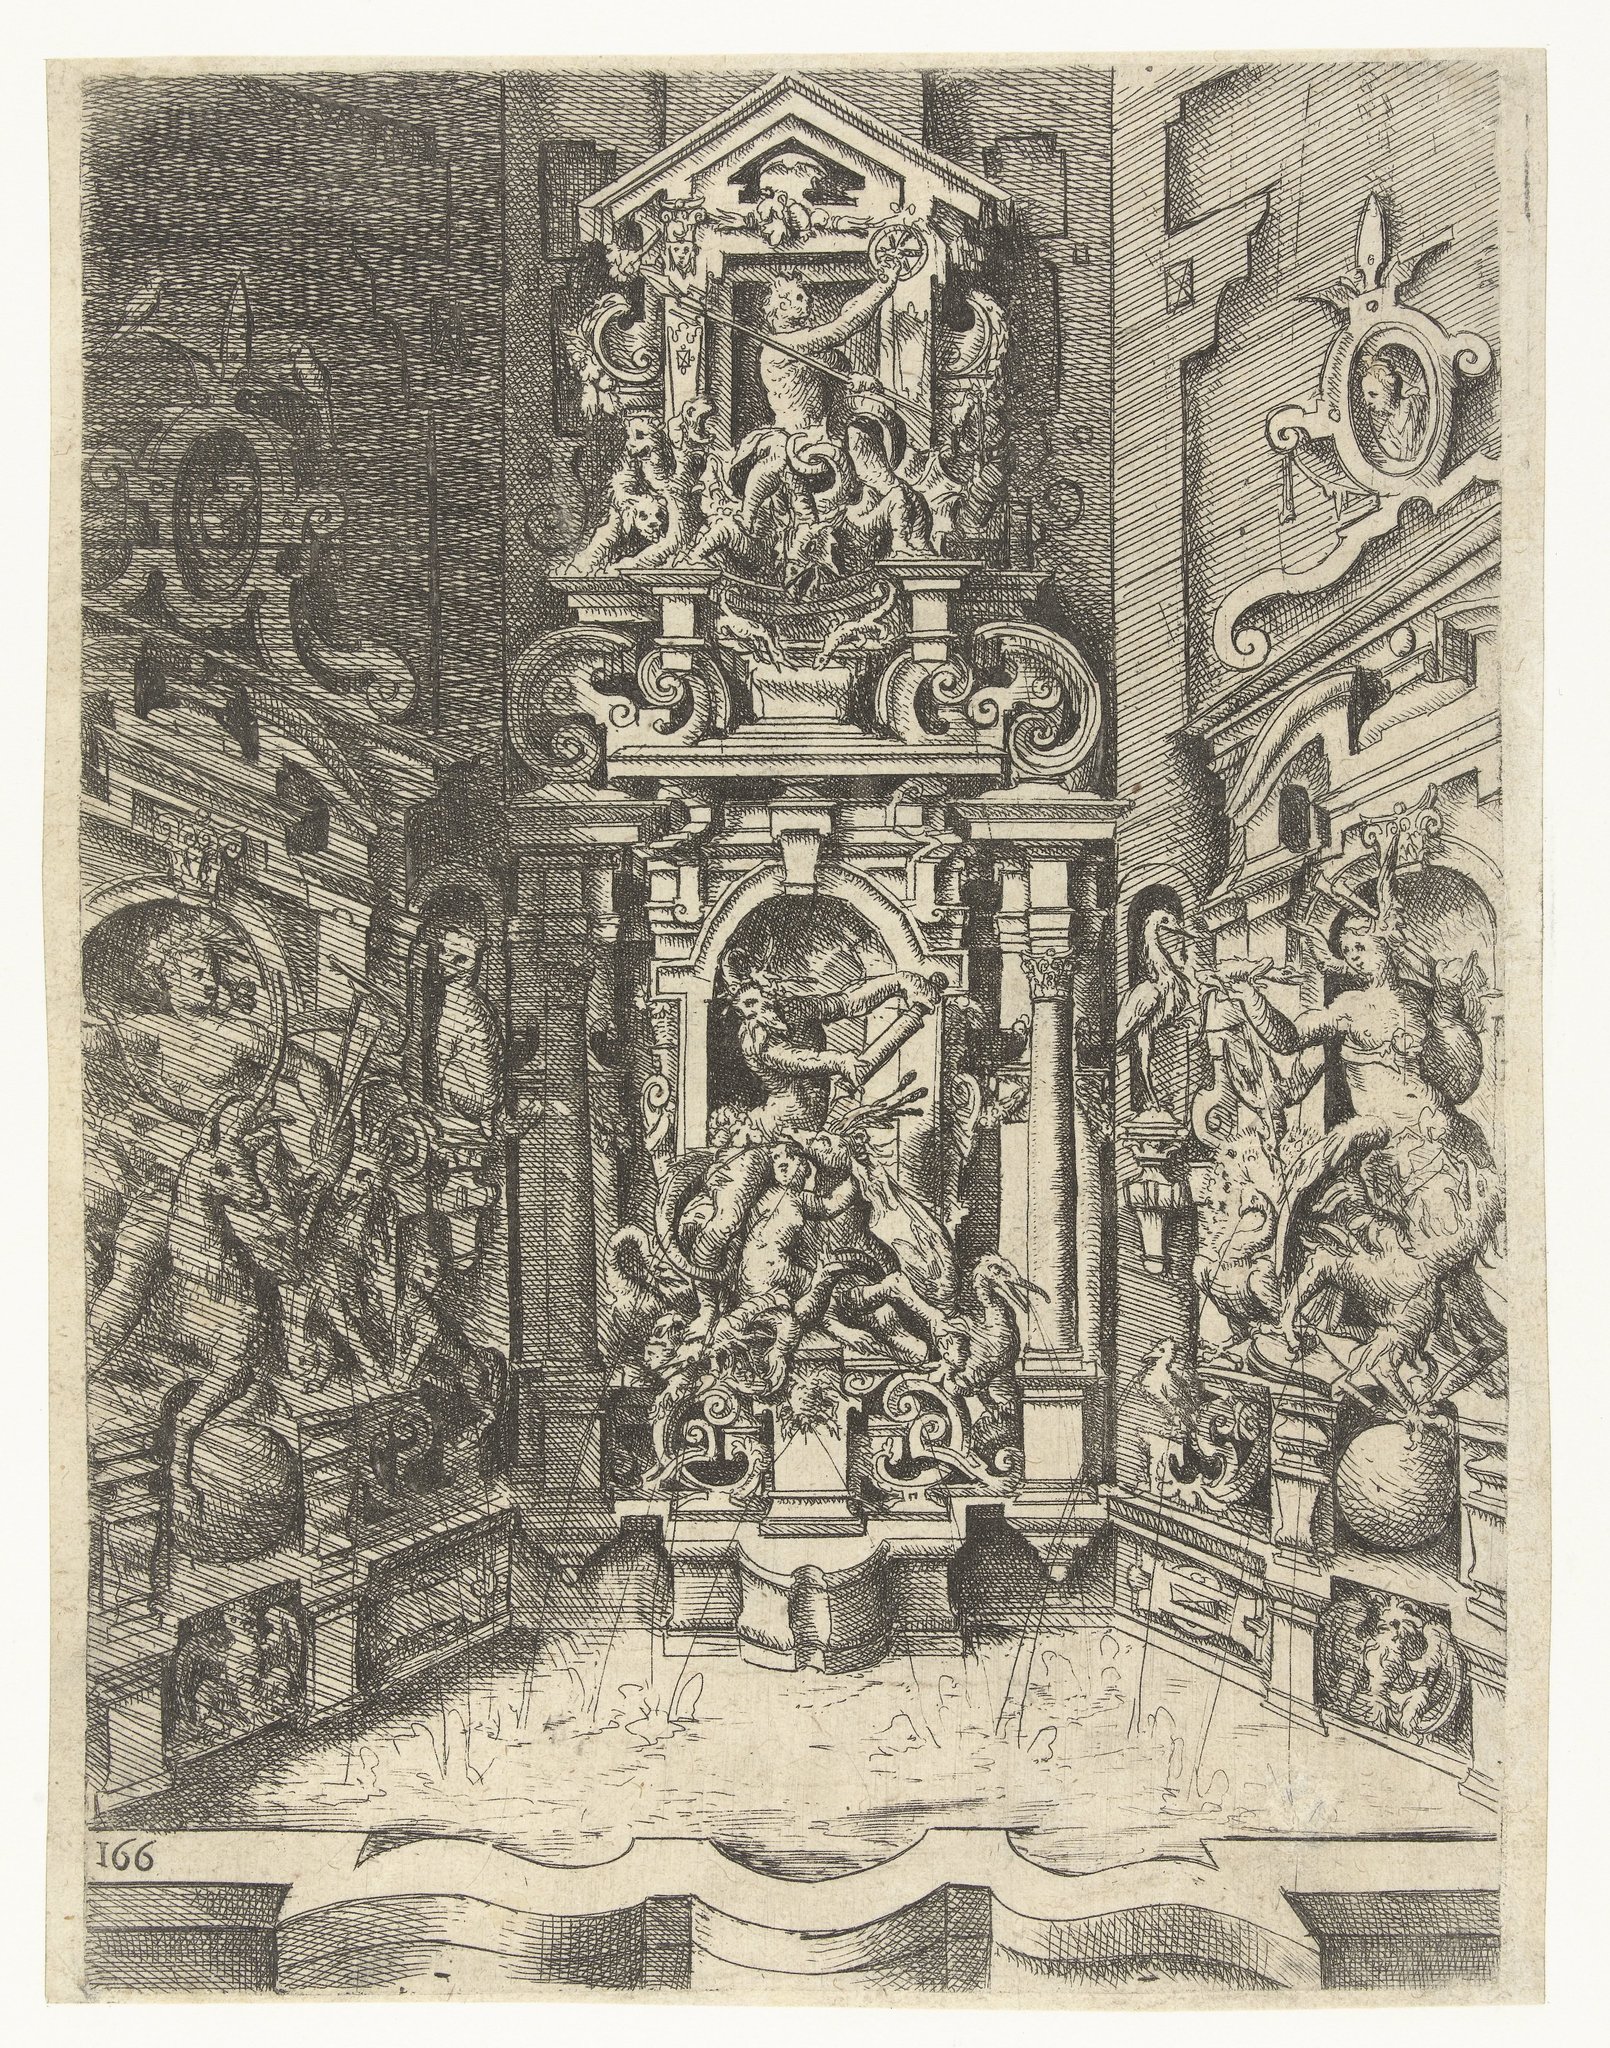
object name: ornament print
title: Waterbassin, nr 166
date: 1560-1598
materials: paper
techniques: etching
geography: germany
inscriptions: inscription: ‘4-5-'77’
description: Links is de fontein met Ceres zichtbaar (zie RP-P-1973-122), tegen de achterwand twee fonteinen, de onderste met een zeegod en rechts een fontein met een vrouw, omringd door dieren. Eén van 20 bladen uit een serie (Architectura. Von Ausztheilung, Symmetria und Proportion der fünff Seulen...) bestaande uit 193 bladen en 5 titelbladen, verdeeld over vijf boeken. Het gaat hier om een tweede, uitgebreide editie van de onder Orn Cat I-319 beschreven serie.